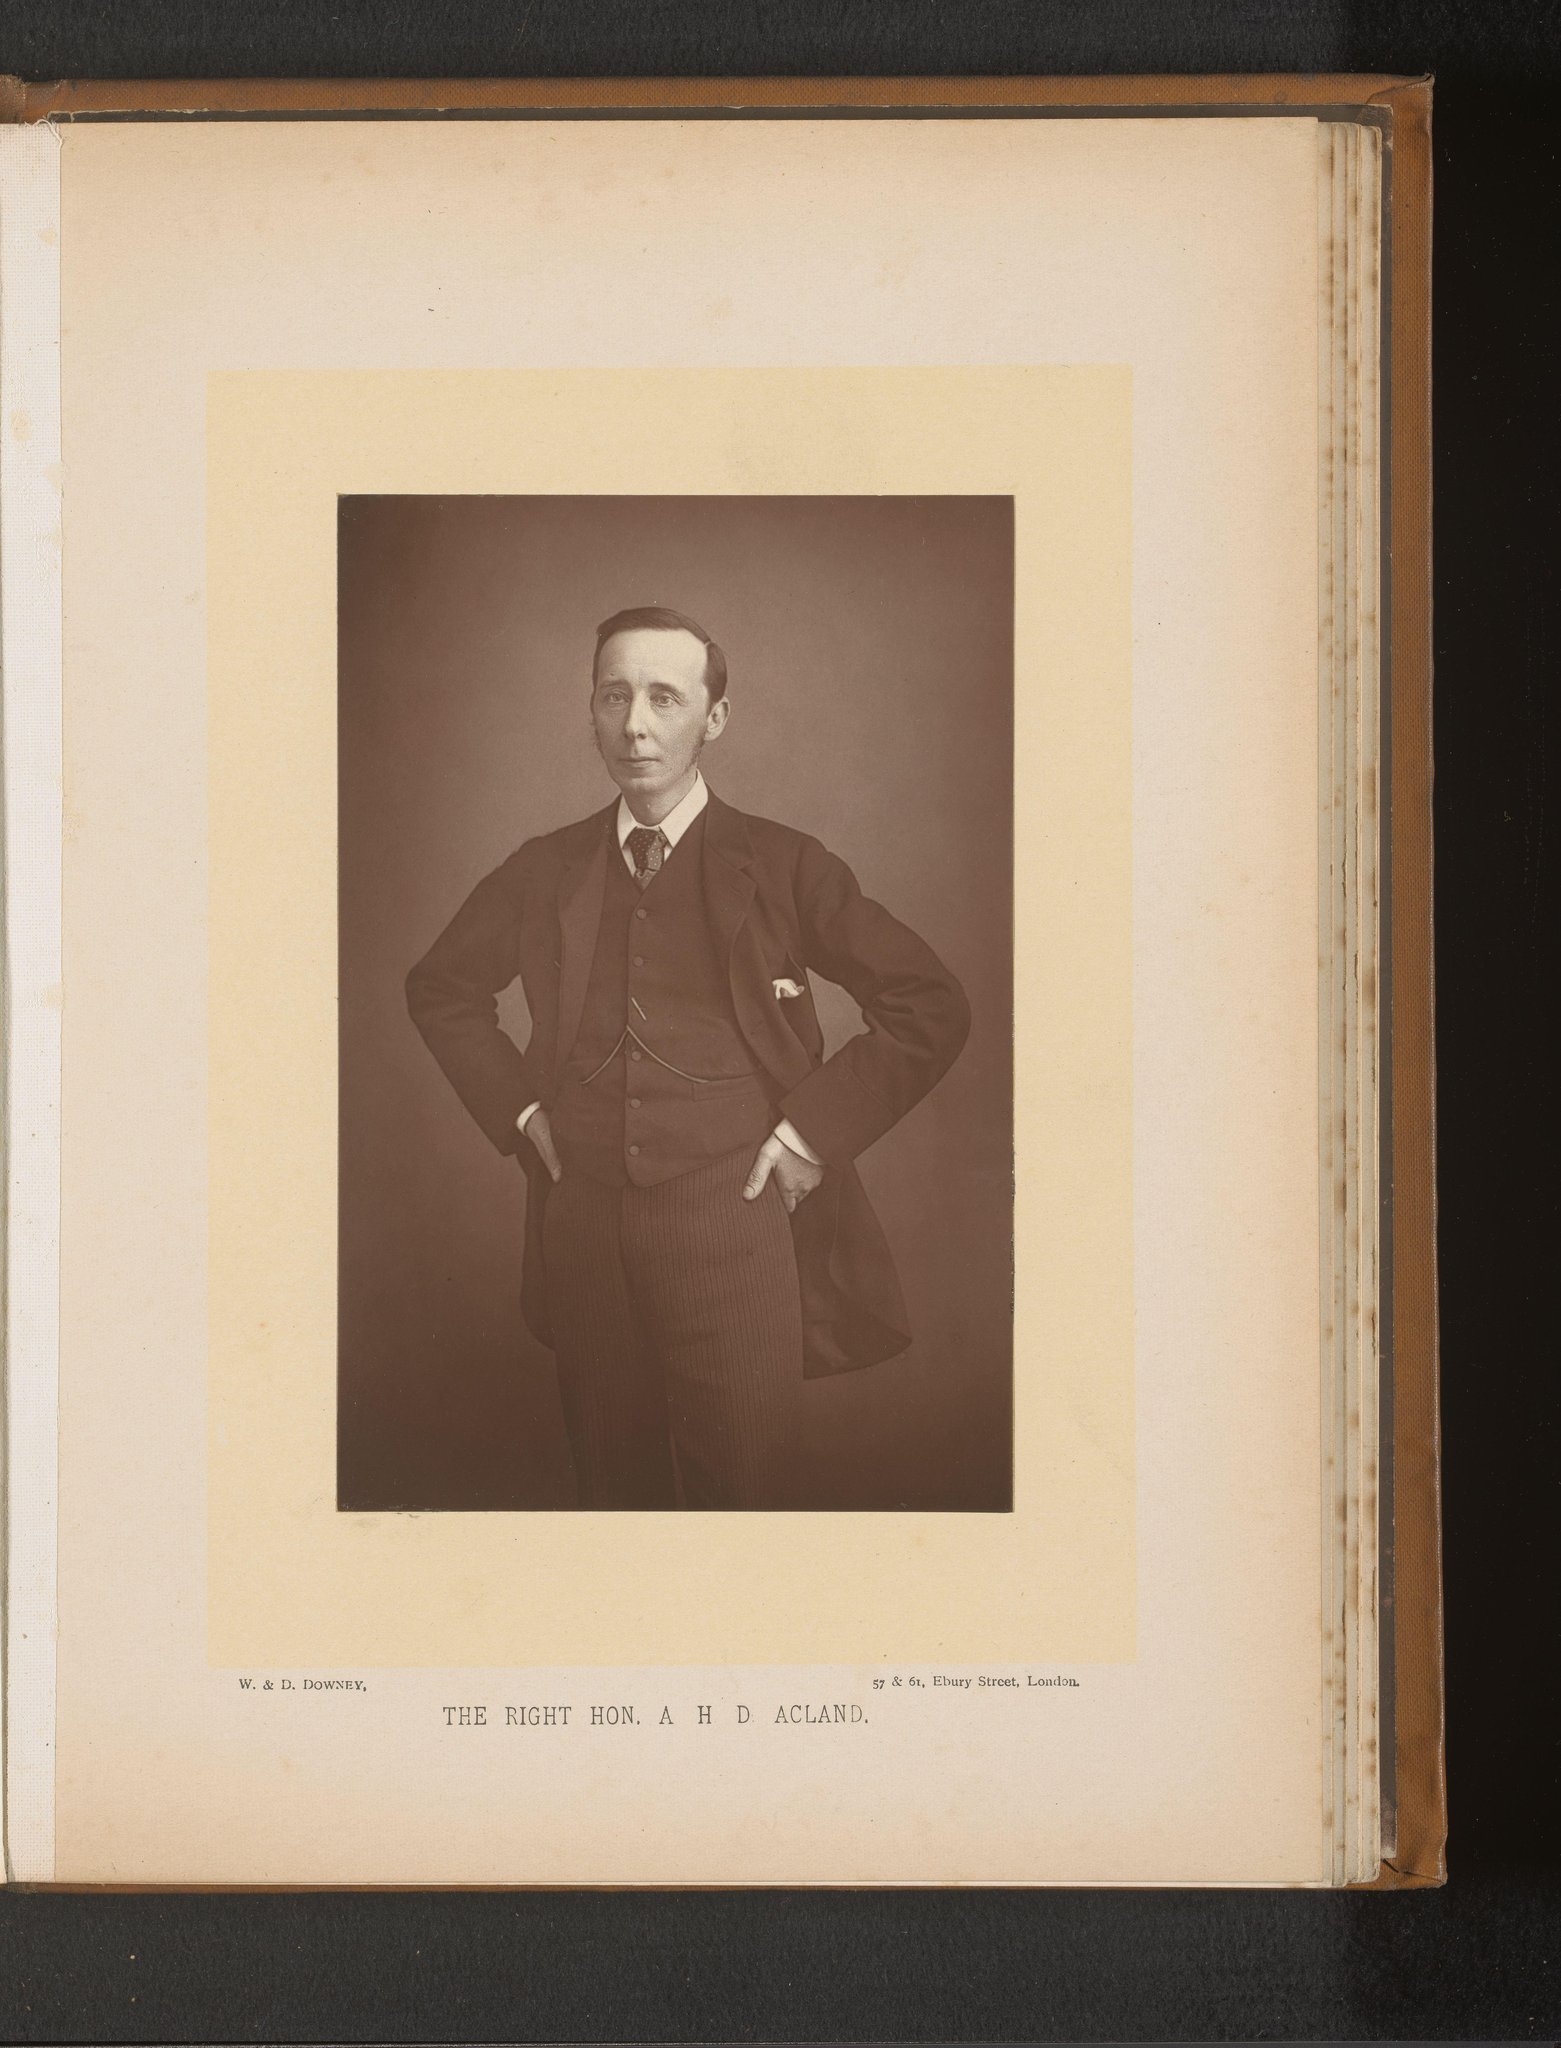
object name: photomechanical print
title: The right Hon. A.H.D. Acland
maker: Anonymous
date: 1884-1894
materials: paper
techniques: woodburytype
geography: london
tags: politician, politician, e.g. party leader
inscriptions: inscription: ‘57 & 61, Elbury Street, London.’